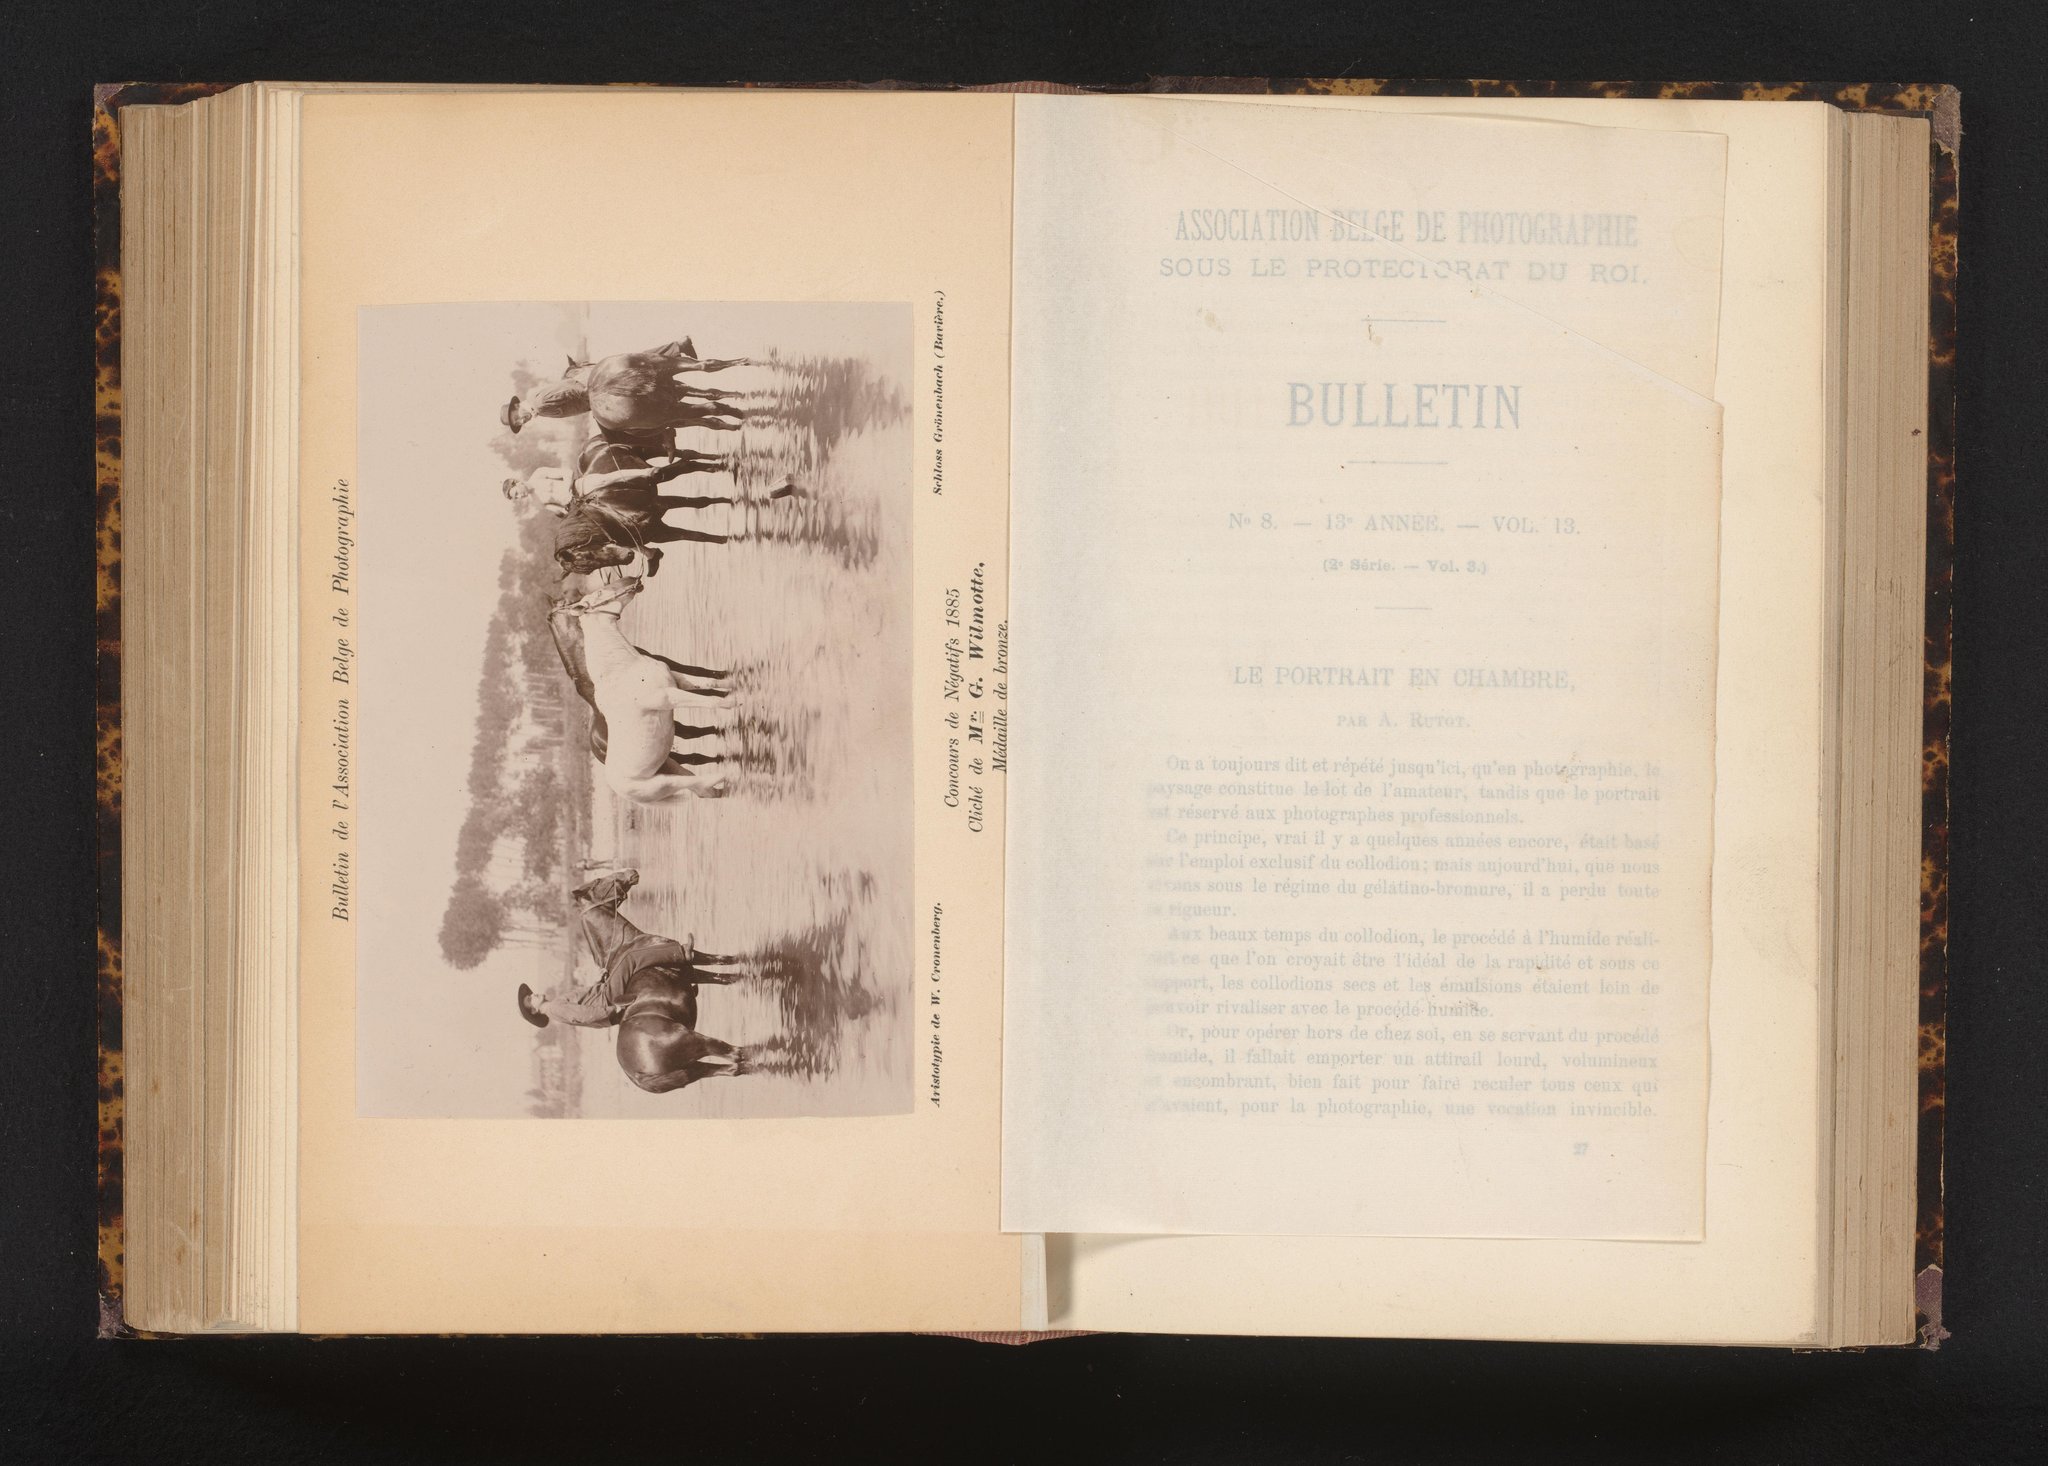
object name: photograph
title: Onbekende mannen te paard in het water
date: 1881-1886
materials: paper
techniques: collodion silver print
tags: historical persons, animal mounts; pack-animals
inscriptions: inscription: ‘Bulletin de l'association belge de photographie / Schloss-Gronenbach (Bavière )’, inscription: ‘Concours de négatifs 1885’